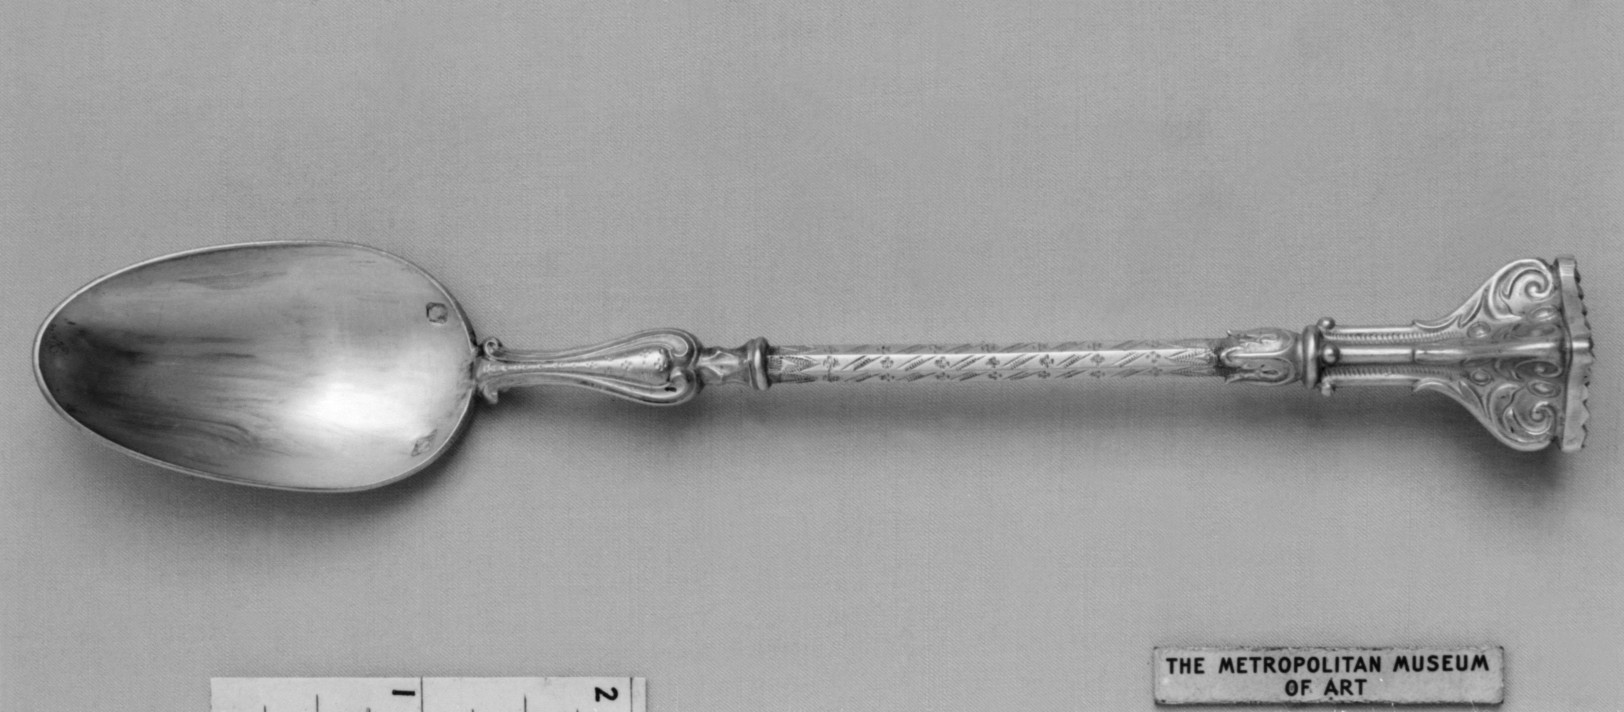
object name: spoon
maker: a.d. boulenger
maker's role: maker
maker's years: 1800-1900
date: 1834-1866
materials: silver